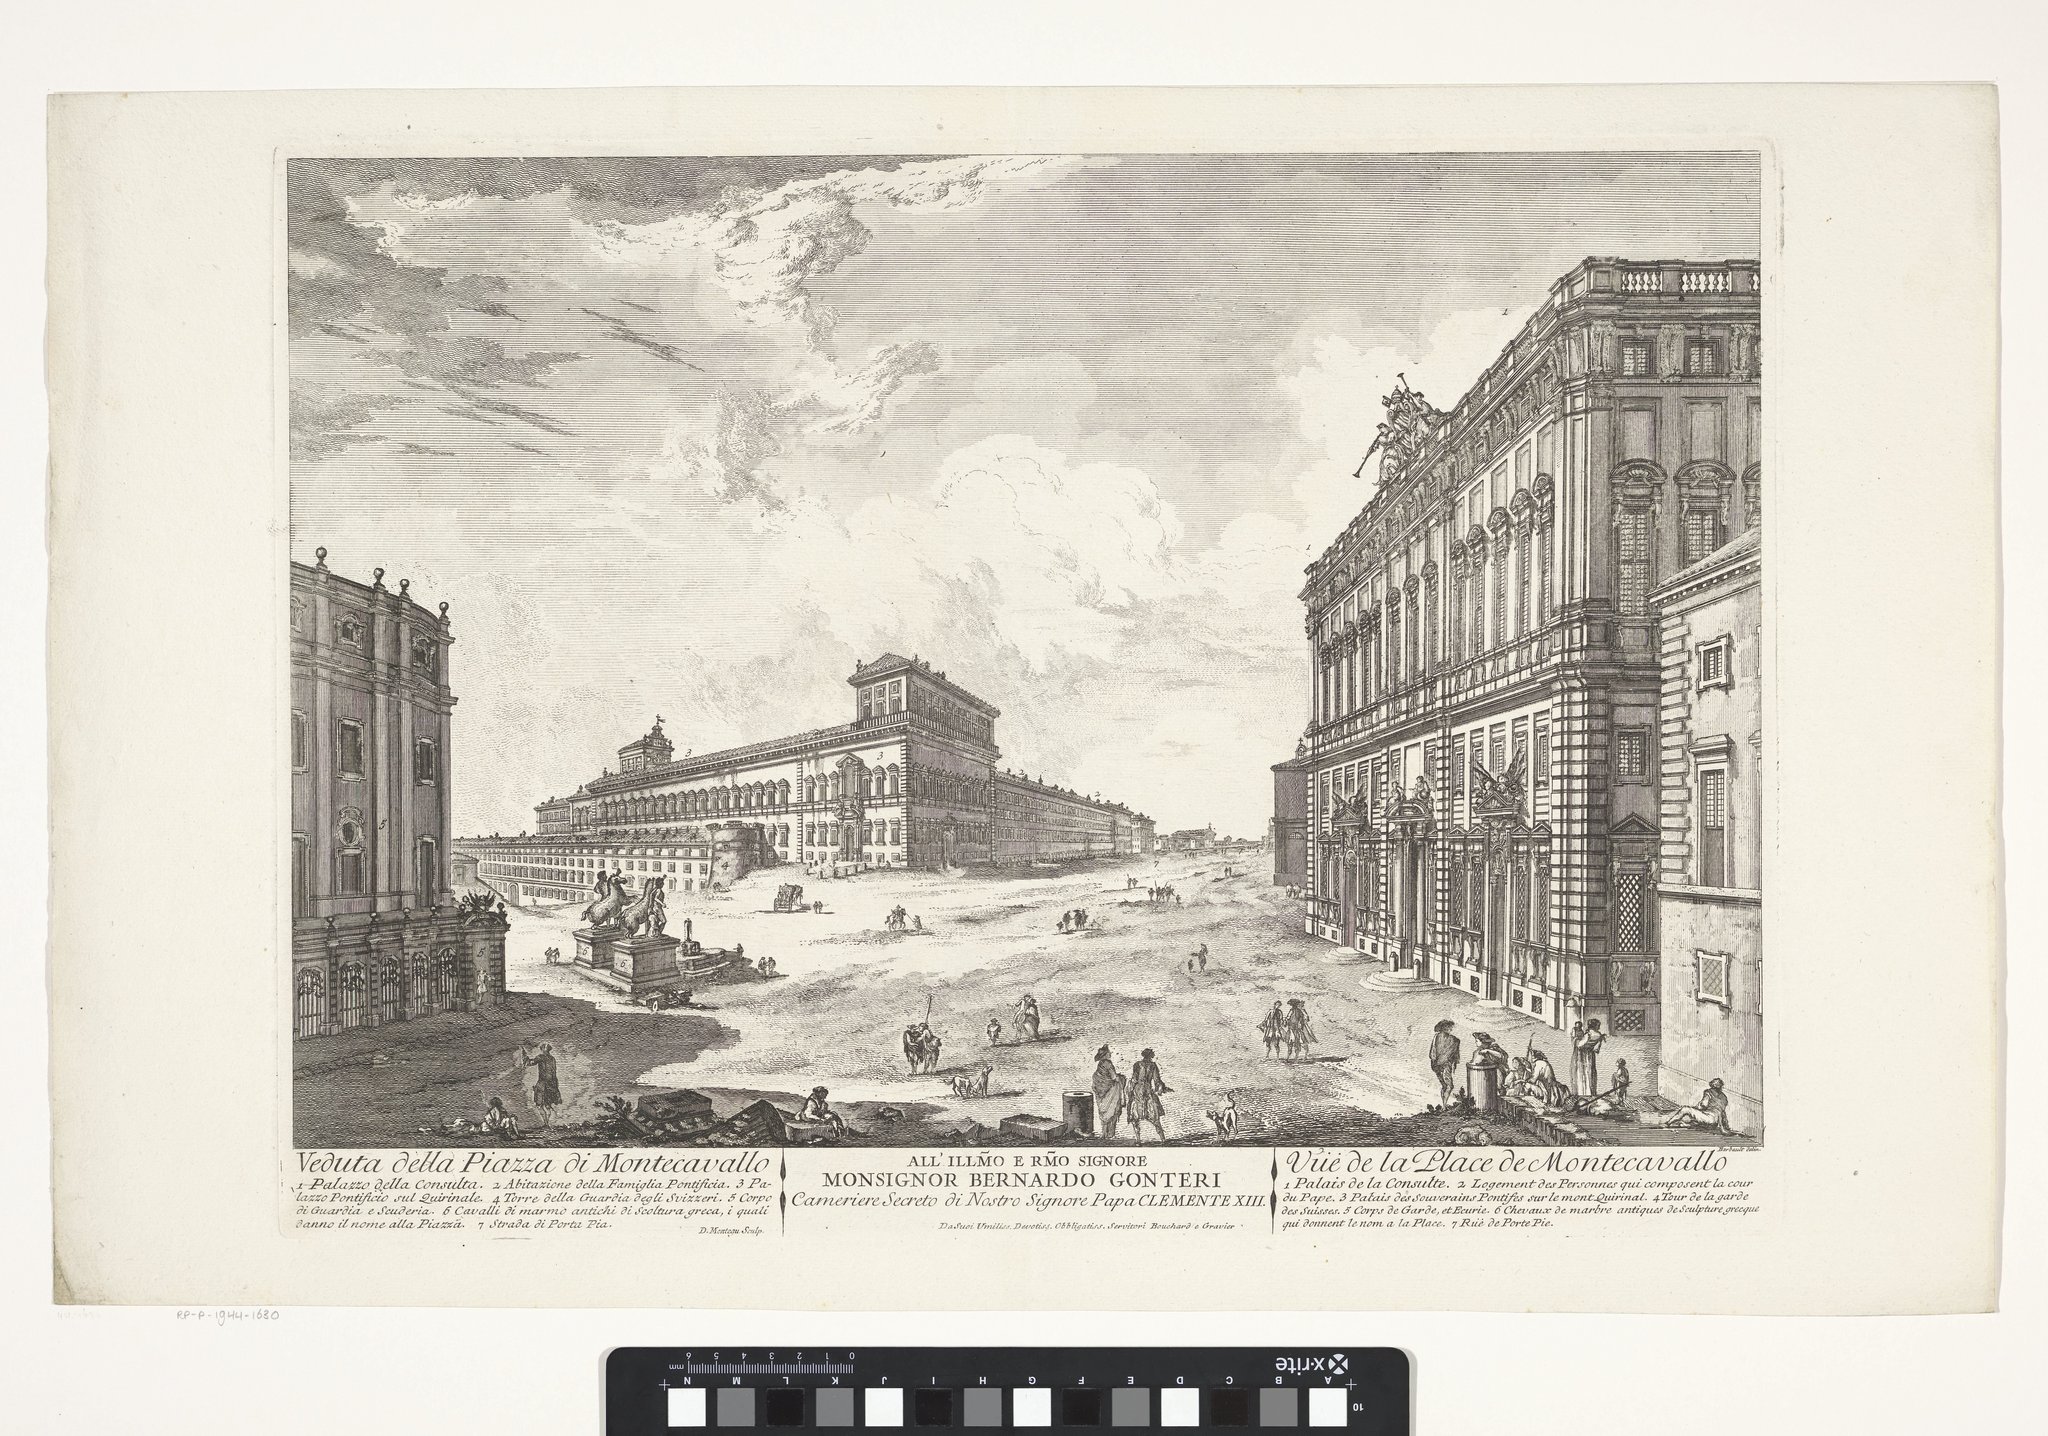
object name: print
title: Piazza del Quirinale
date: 1750-1799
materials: paper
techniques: etching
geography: italy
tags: city-view, and landscape with man-made constructions, rome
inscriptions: collector's mark: Lugt 2228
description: Gezicht op het Piazza del Quirinale op de Quirinaalheuvel te Rome met het Palazzo del Quirinale en de Fontana di Monte Cavallo (fontein met Castor en Pollux). Titels en verklarende lijsten met nummers in het Frans en Italiaans en een opdracht in de ondermarge.